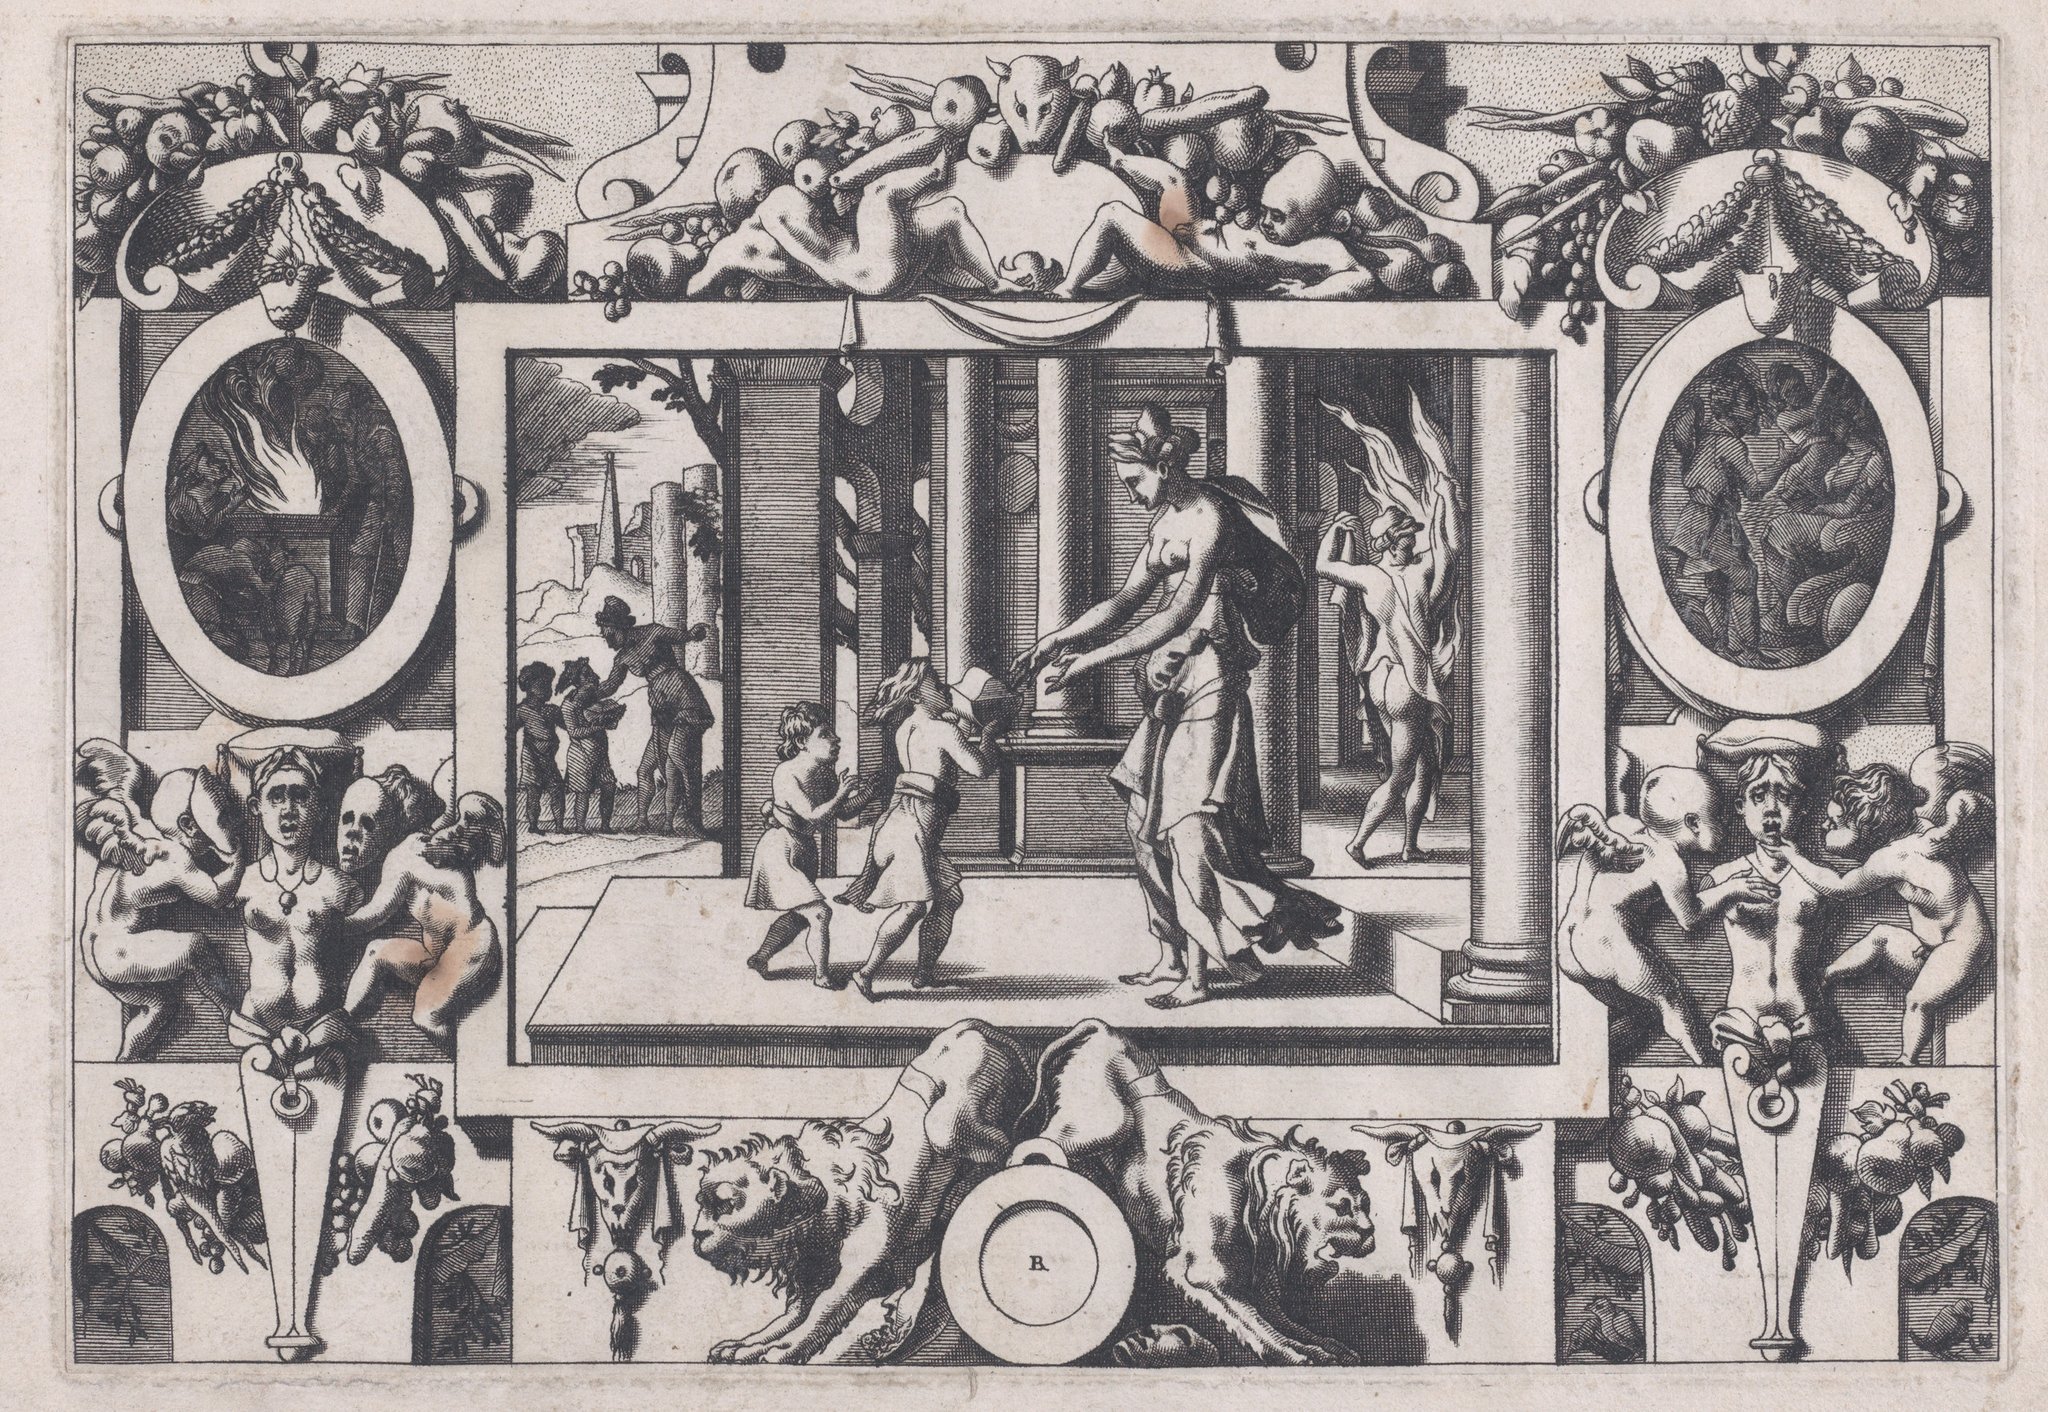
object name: print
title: The Children of Medea and Jason Give Creusa the Fatal Present (Par ses deux fils à l'épouse nouvelle envoyé en don la couronne mortelle...), from "Jason and the Golden Fleece"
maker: rené boyvin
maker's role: artist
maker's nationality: french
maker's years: 1525-1598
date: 1563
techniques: engraving